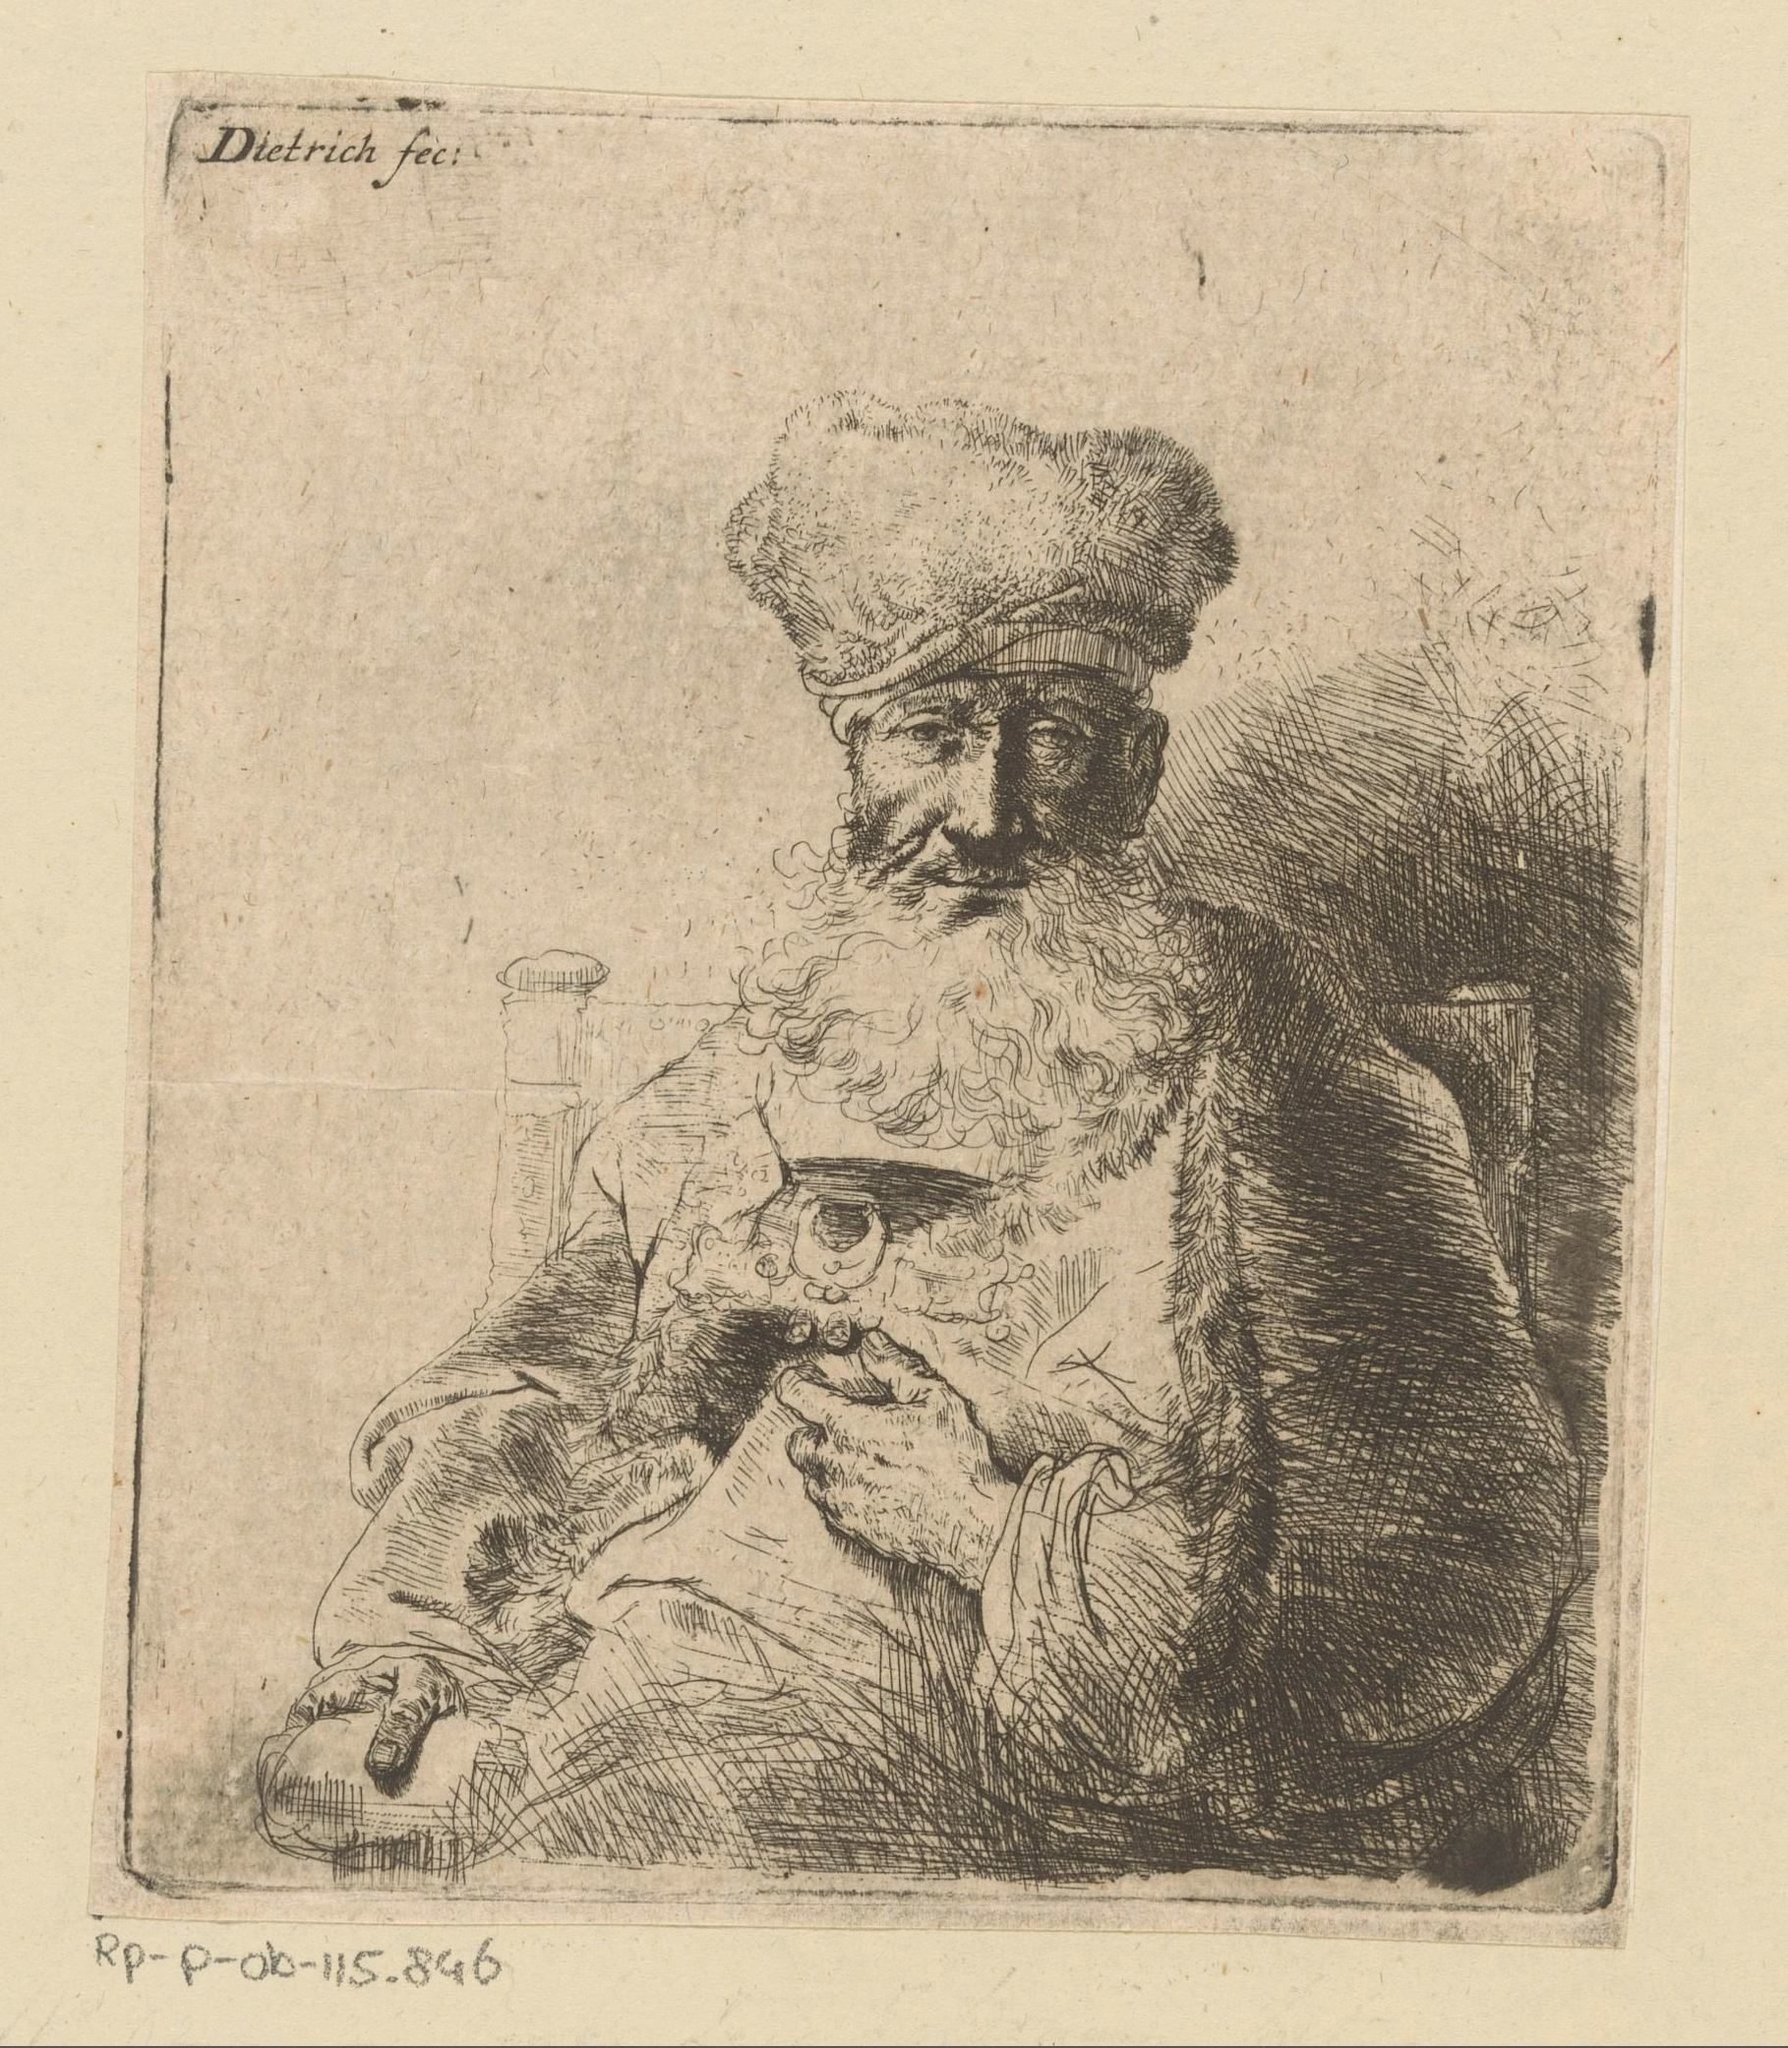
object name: print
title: Borstbeeld van een Joodse priester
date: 1722-1774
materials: paper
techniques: etching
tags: vestments of high priest ~ jewish religion, old man, head-gear: turban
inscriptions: collector's mark: Lugt 240